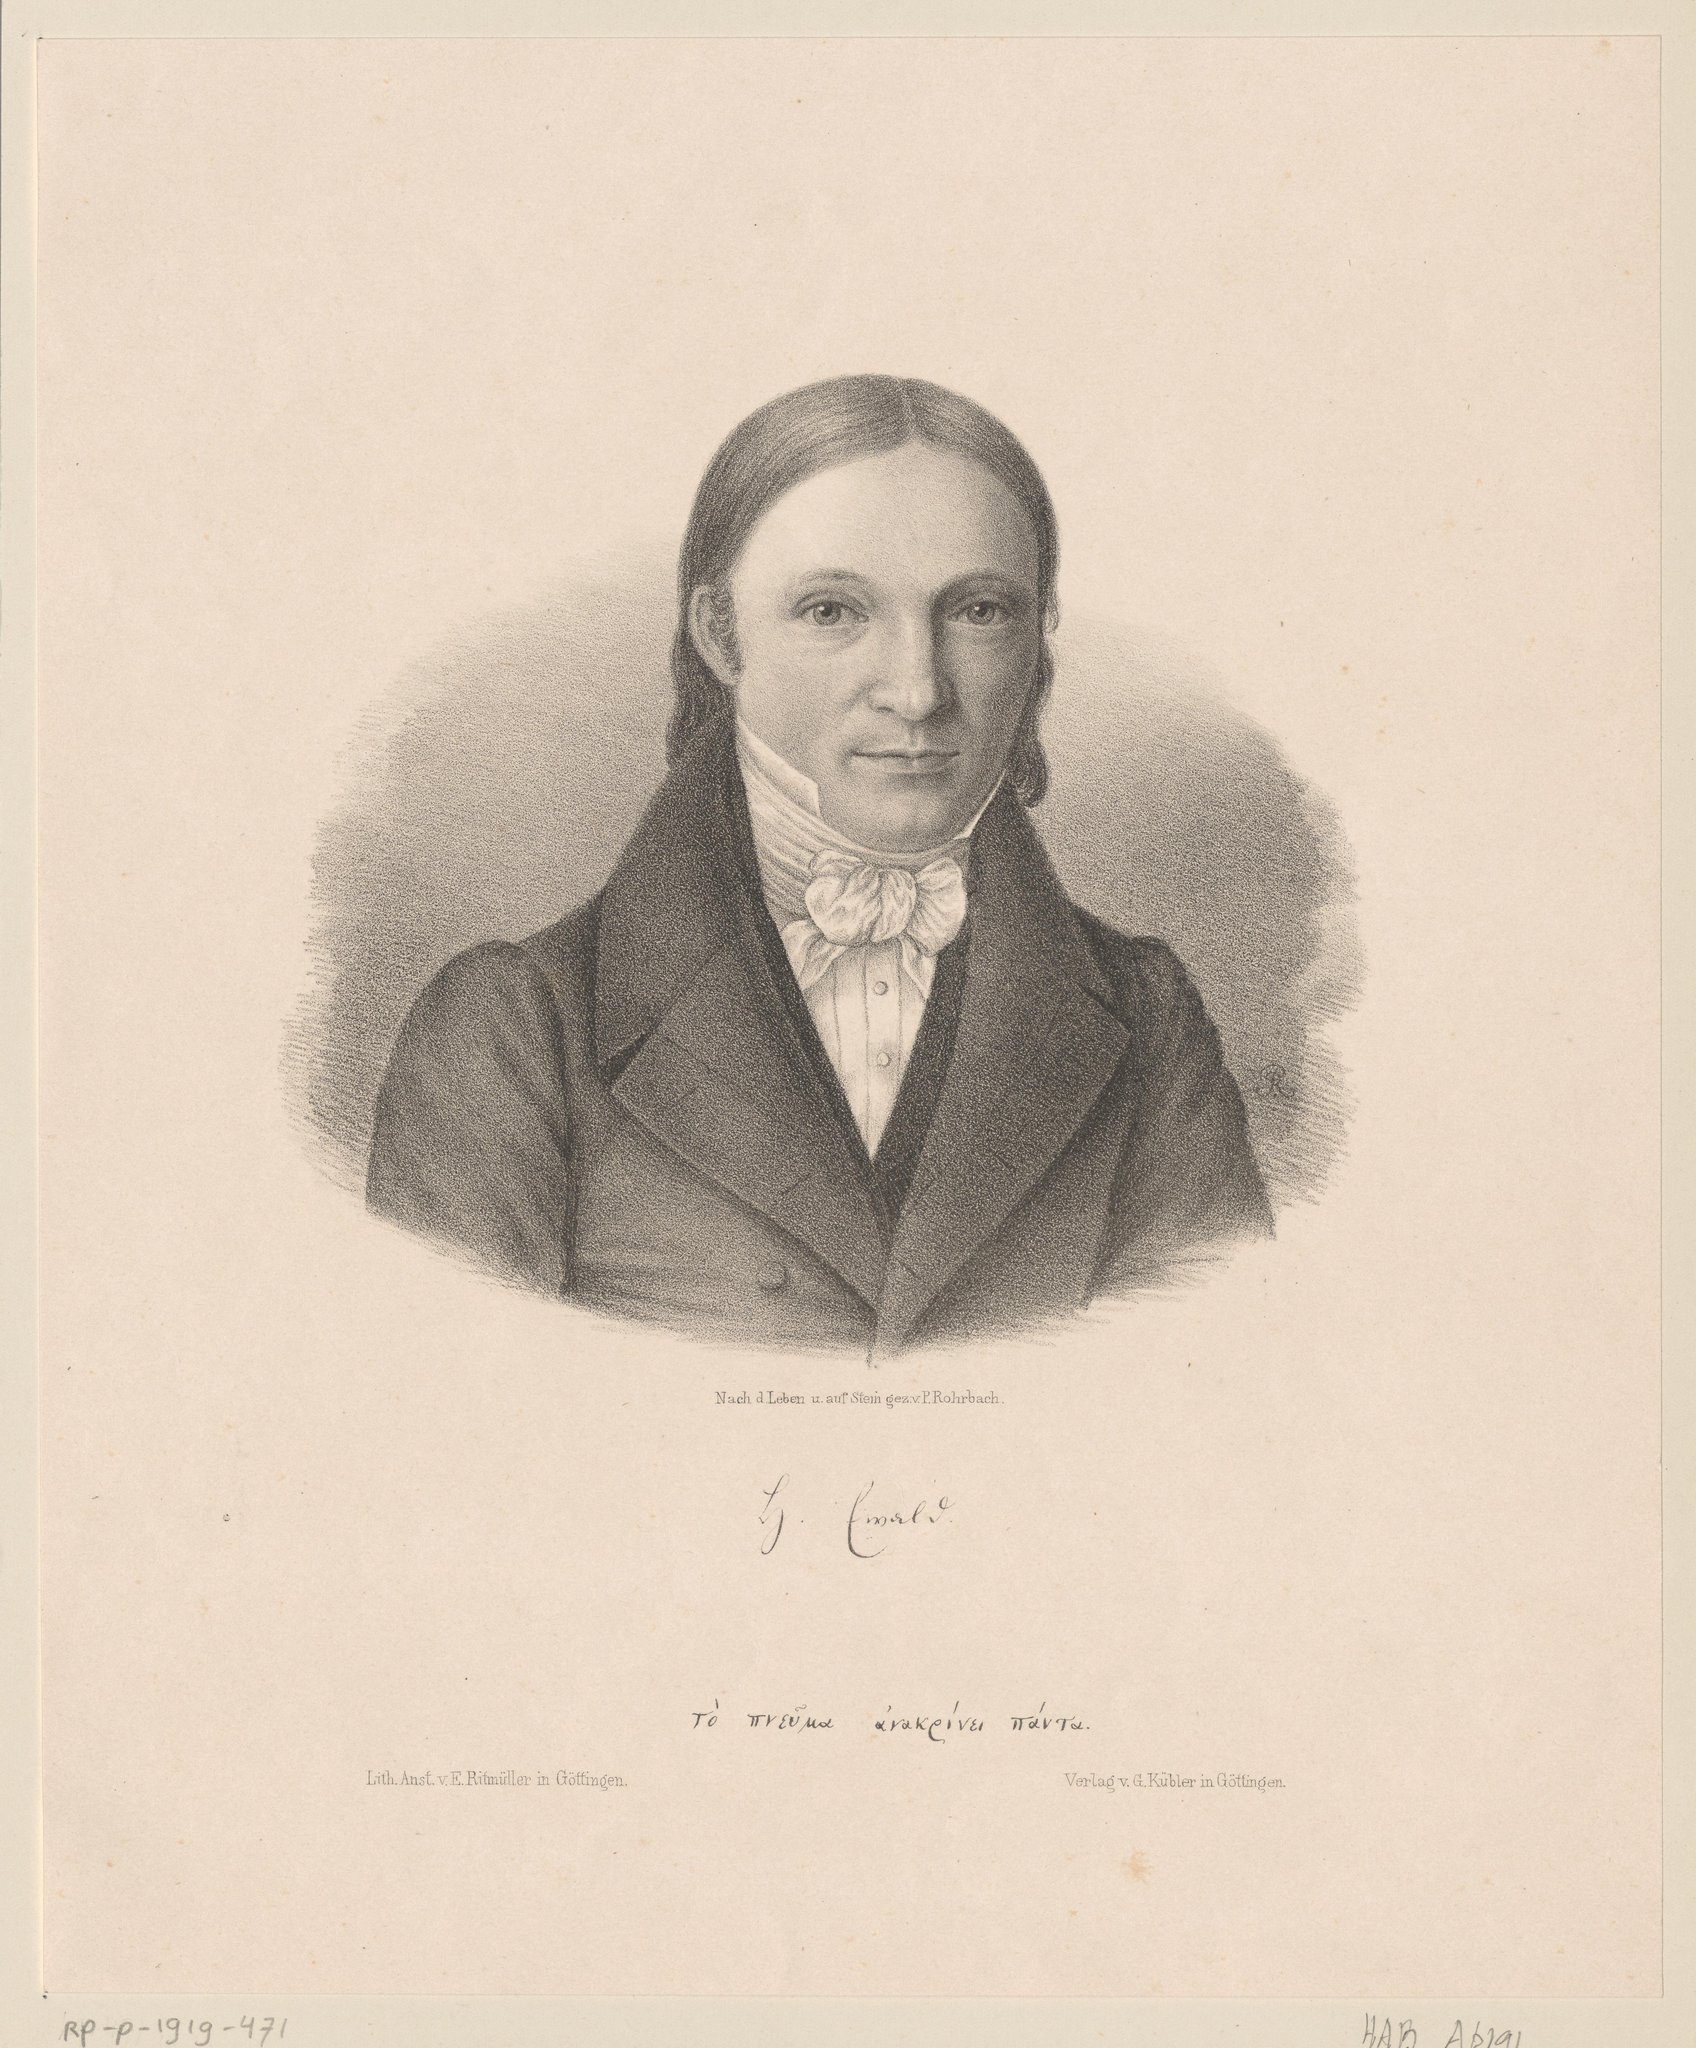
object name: print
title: Portret van Heinrich Ewald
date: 1827-1862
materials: paper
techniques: lithograph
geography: gottingen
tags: historical persons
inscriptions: collector's mark: Lugt 2228